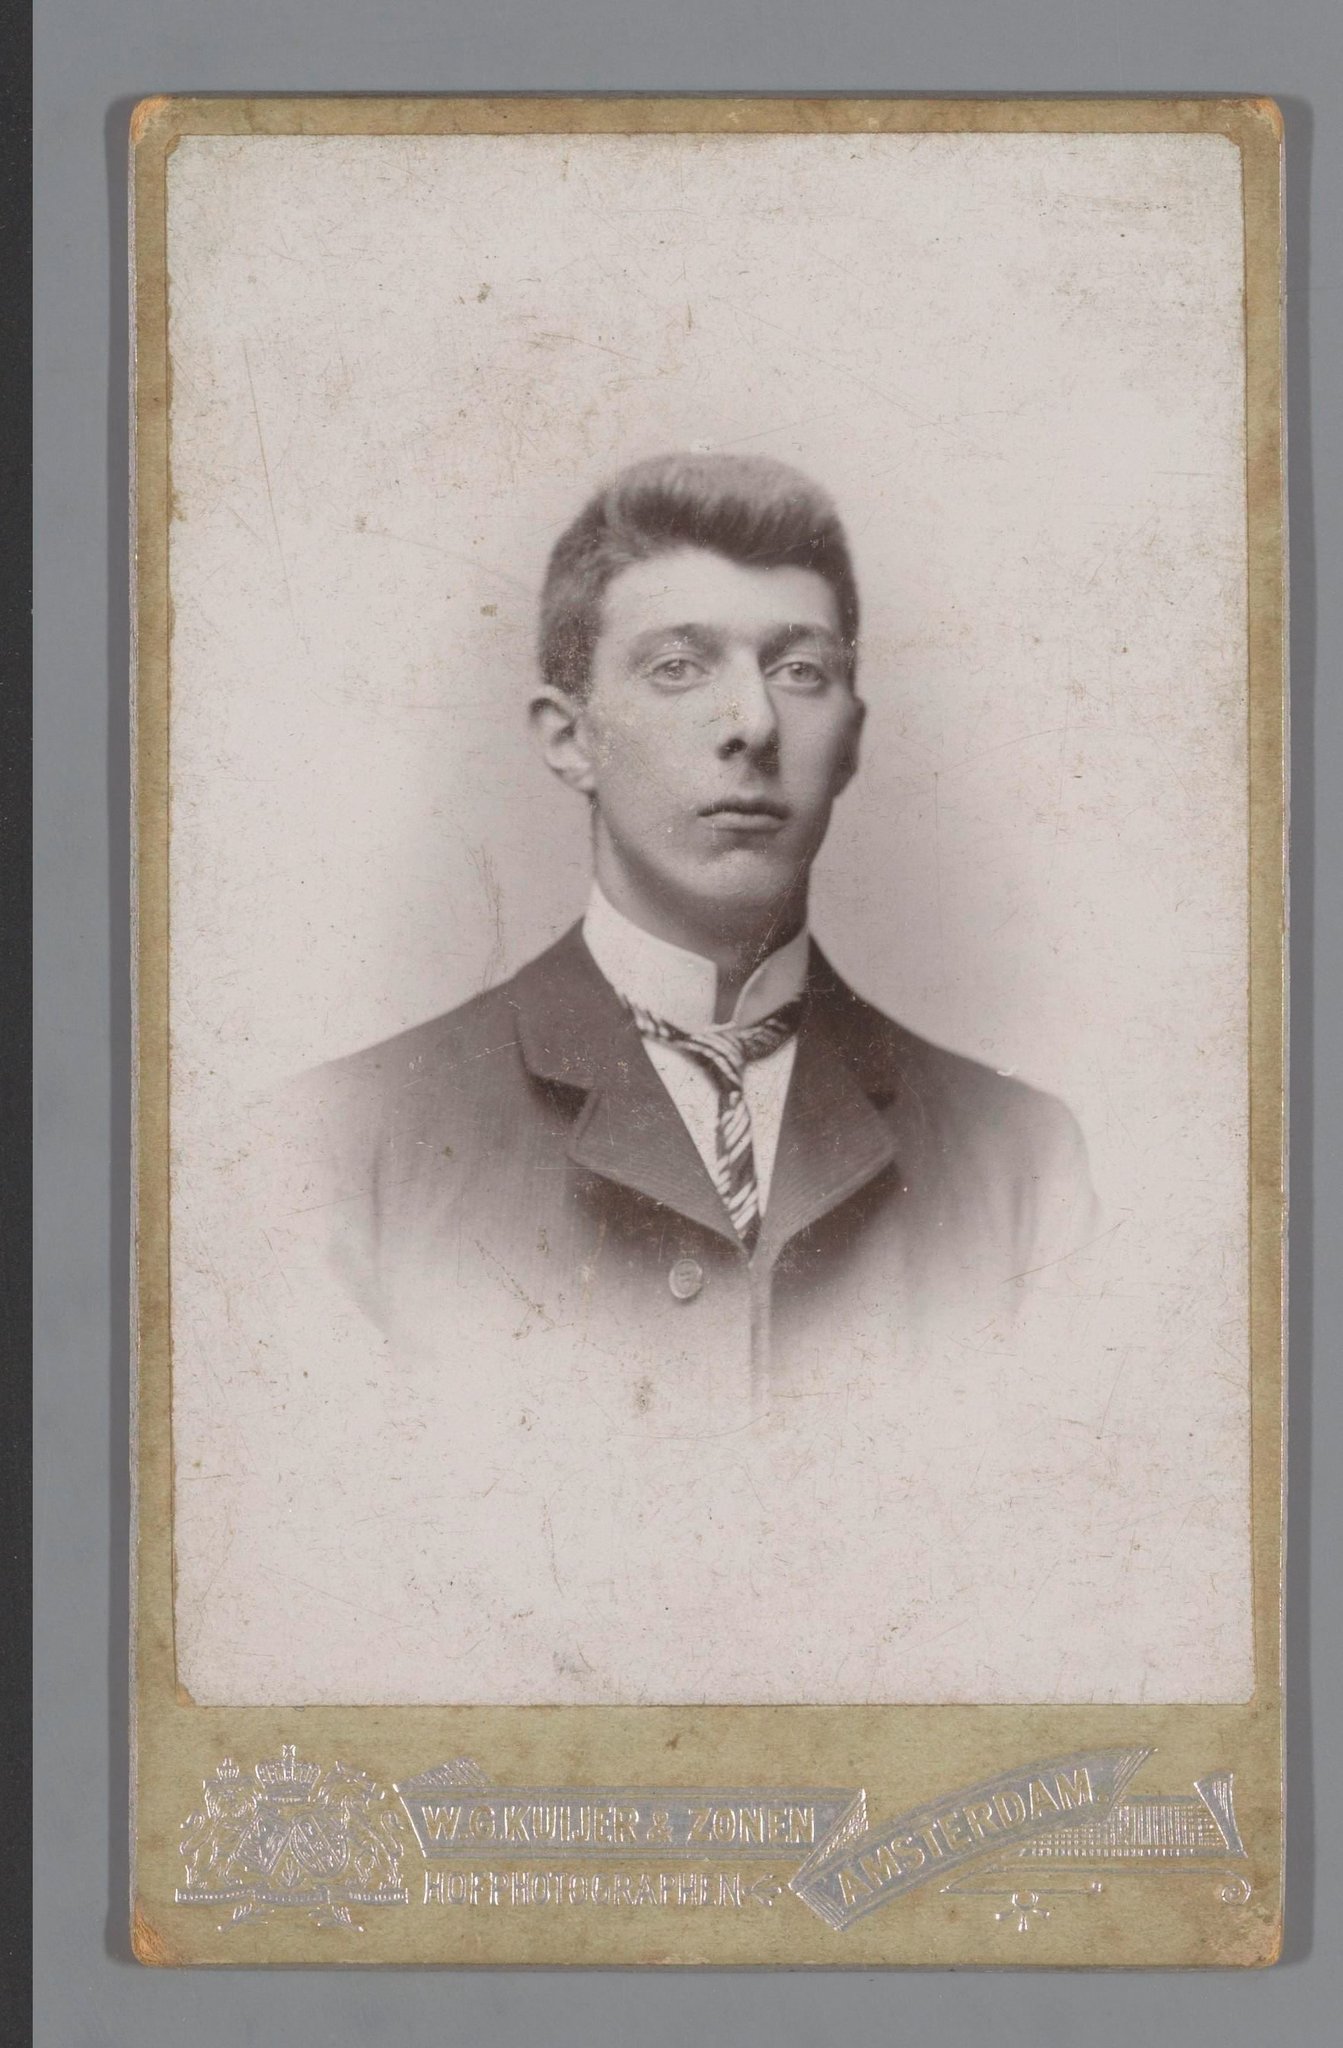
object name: carte de visite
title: Portret van een onbekende man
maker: willem gerhardus kuijer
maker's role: fotograaf, hoffotograaf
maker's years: 1834-1899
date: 1862-1899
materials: cardboard, paper, photographic support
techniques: daylight paper print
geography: amsterdam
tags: adult man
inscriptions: inscription: ‘Opgericht 1864 W.G. Kuijer & Zonen Hofphotographen Westermarkt 19 Amsterdam. Spéciale Inrichting voor Vergrootingen in alle Formaten.’, name: ‘W.G. Kuijer & Zonen Hofphotographen Amsterdam’